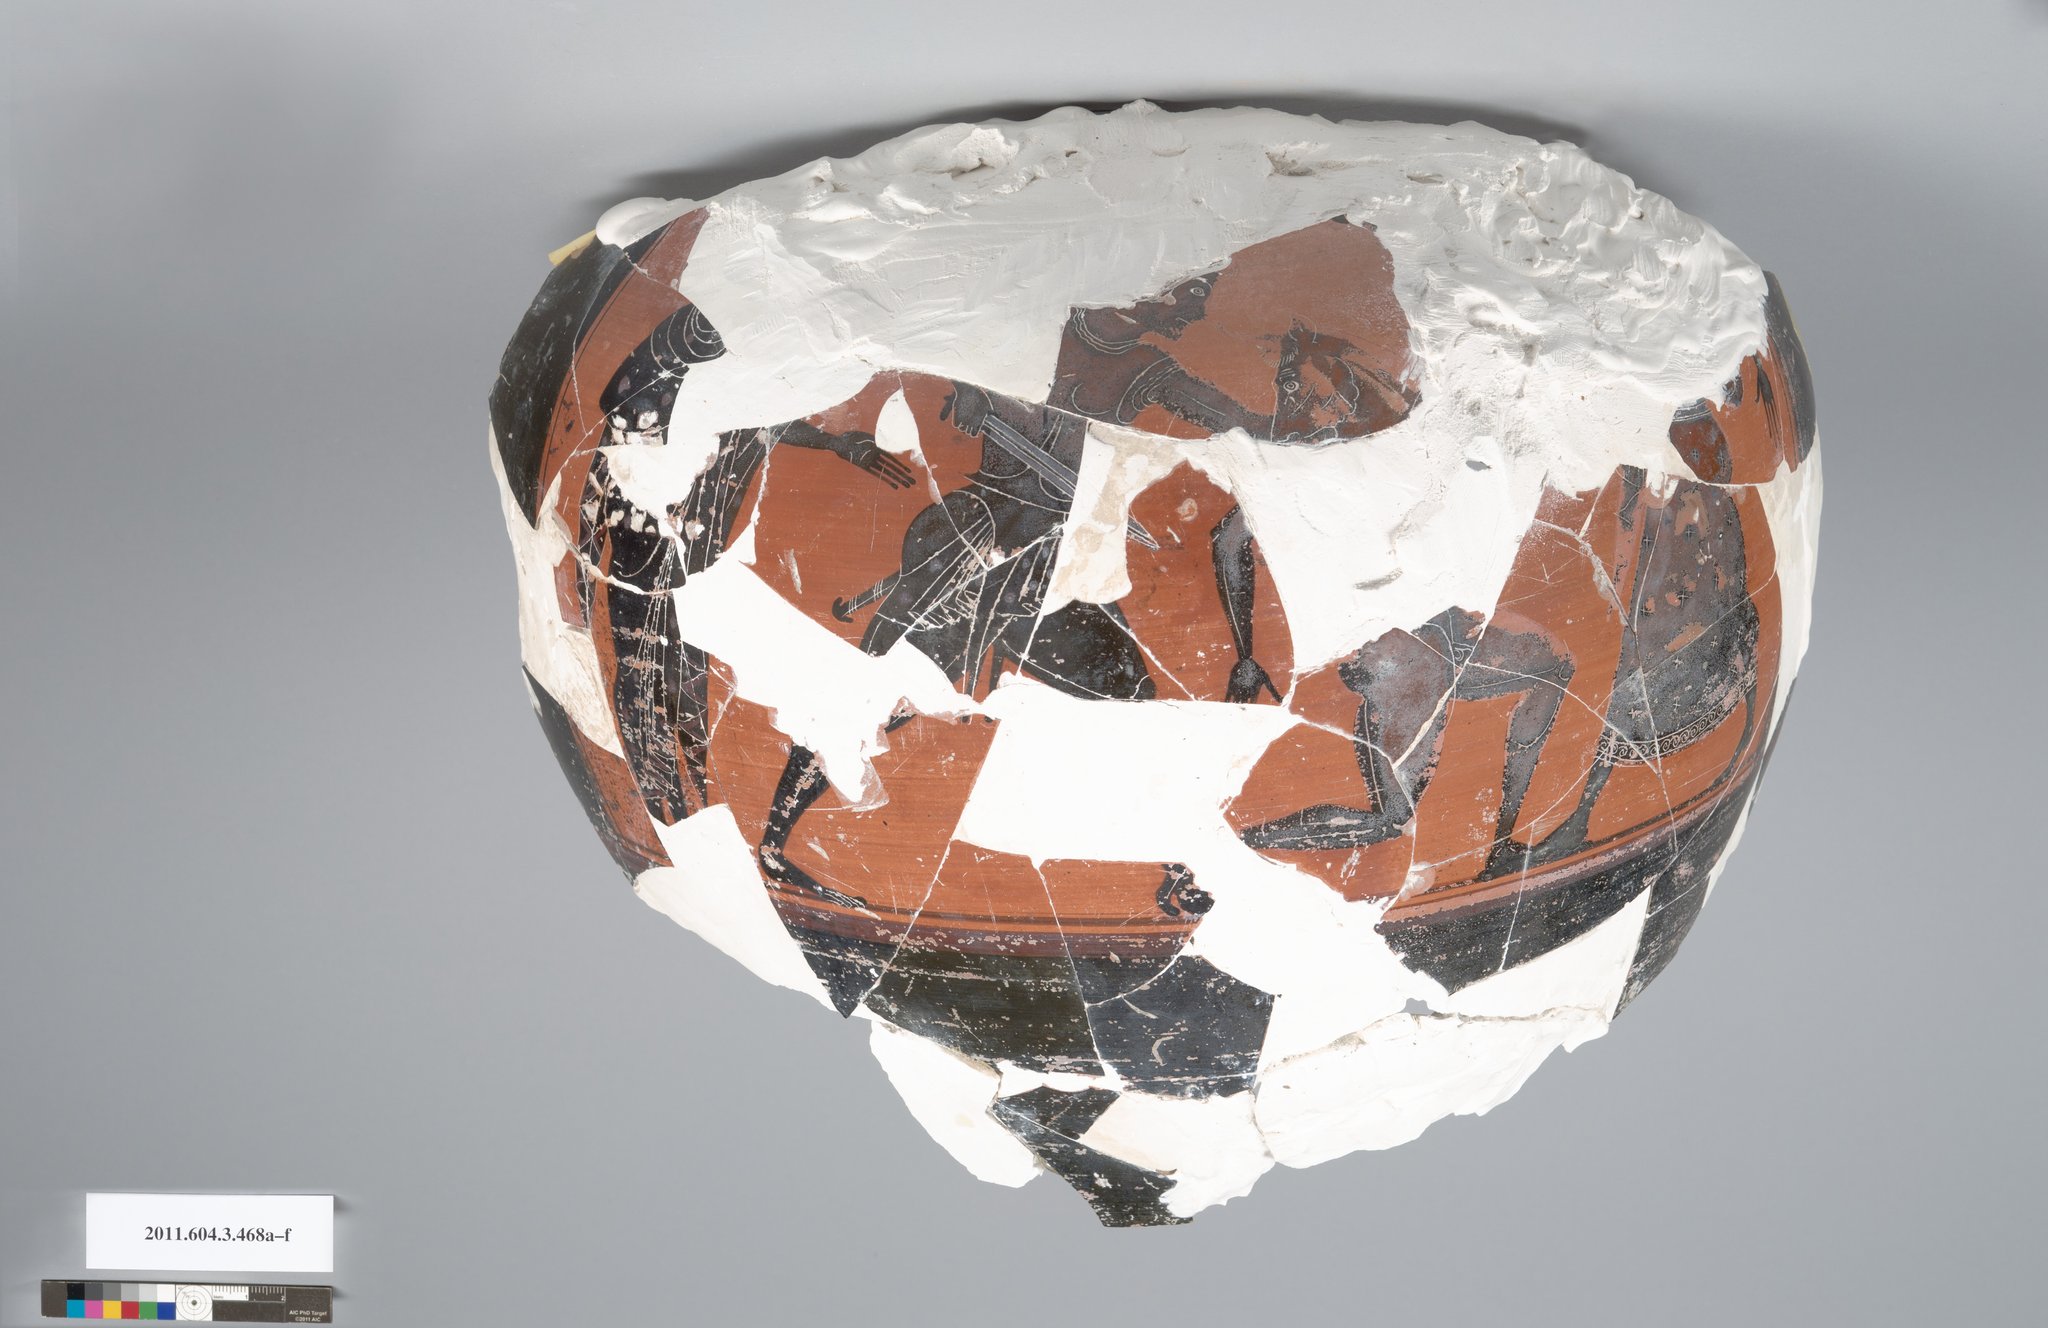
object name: amphora fragment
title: Terracotta fragments of an amphora (jar)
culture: greek, attic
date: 550-526 BCE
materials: terracotta